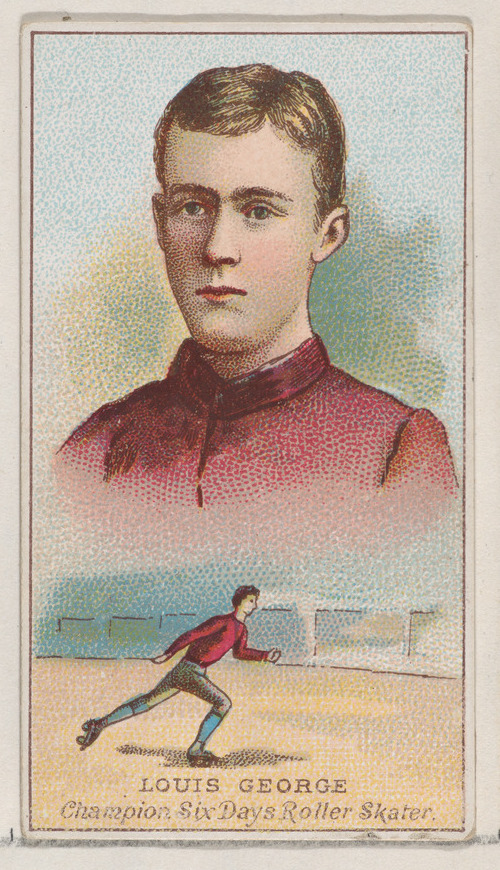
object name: print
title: Louis George, Champion Six Days Roller Skater, from the Champions of Games and Sports series (N184, Type 2) issued by W.S. Kimball & Co.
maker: w.s. kimball & co.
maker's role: publisher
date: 1887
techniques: color lithograph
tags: men,sports,athletes